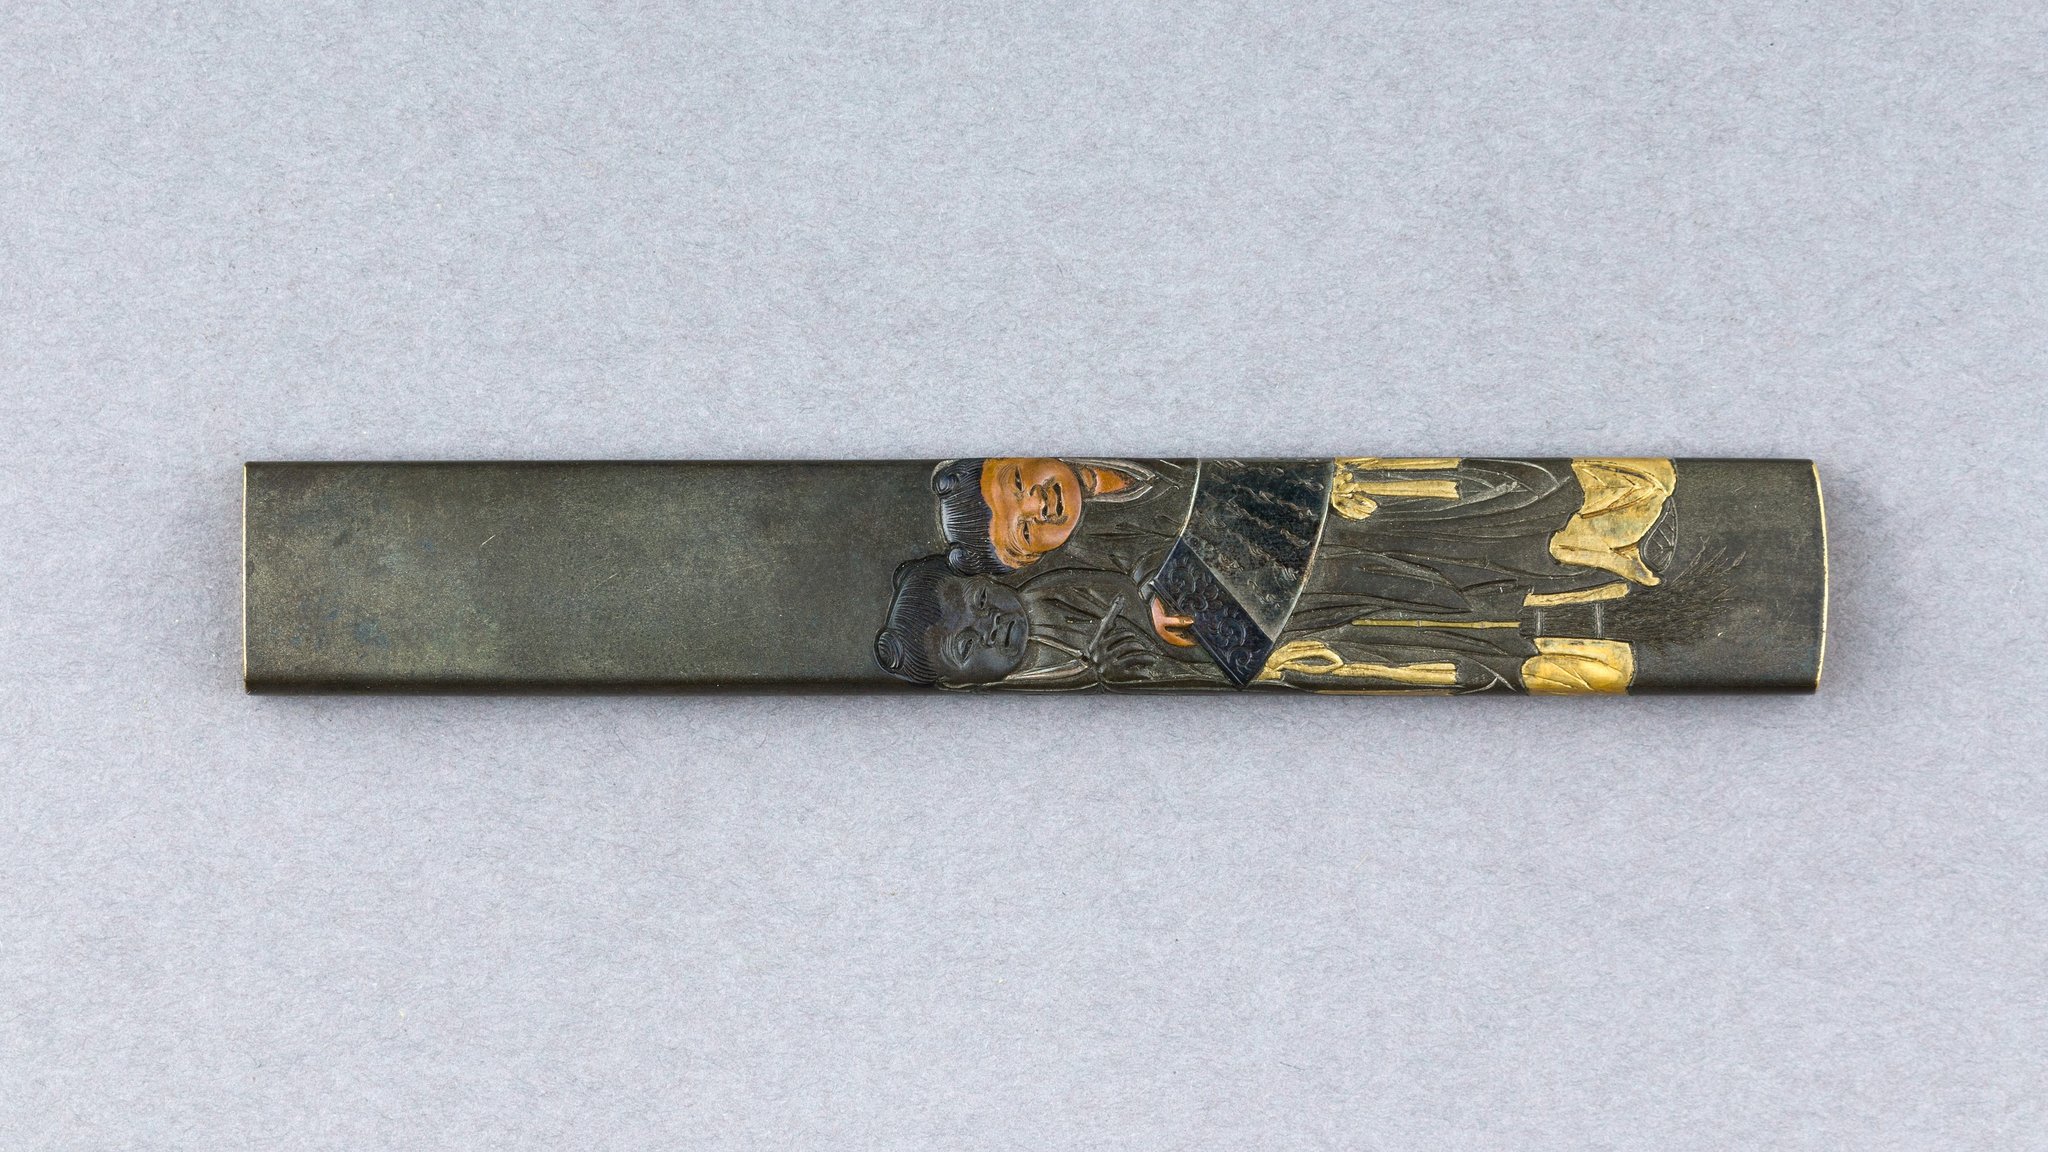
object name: knife handle kozuka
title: Knife Handle (Kozuka)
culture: japanese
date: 1615-1868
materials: copper, gold alloy, silver alloy, gold, silver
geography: japan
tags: human figures